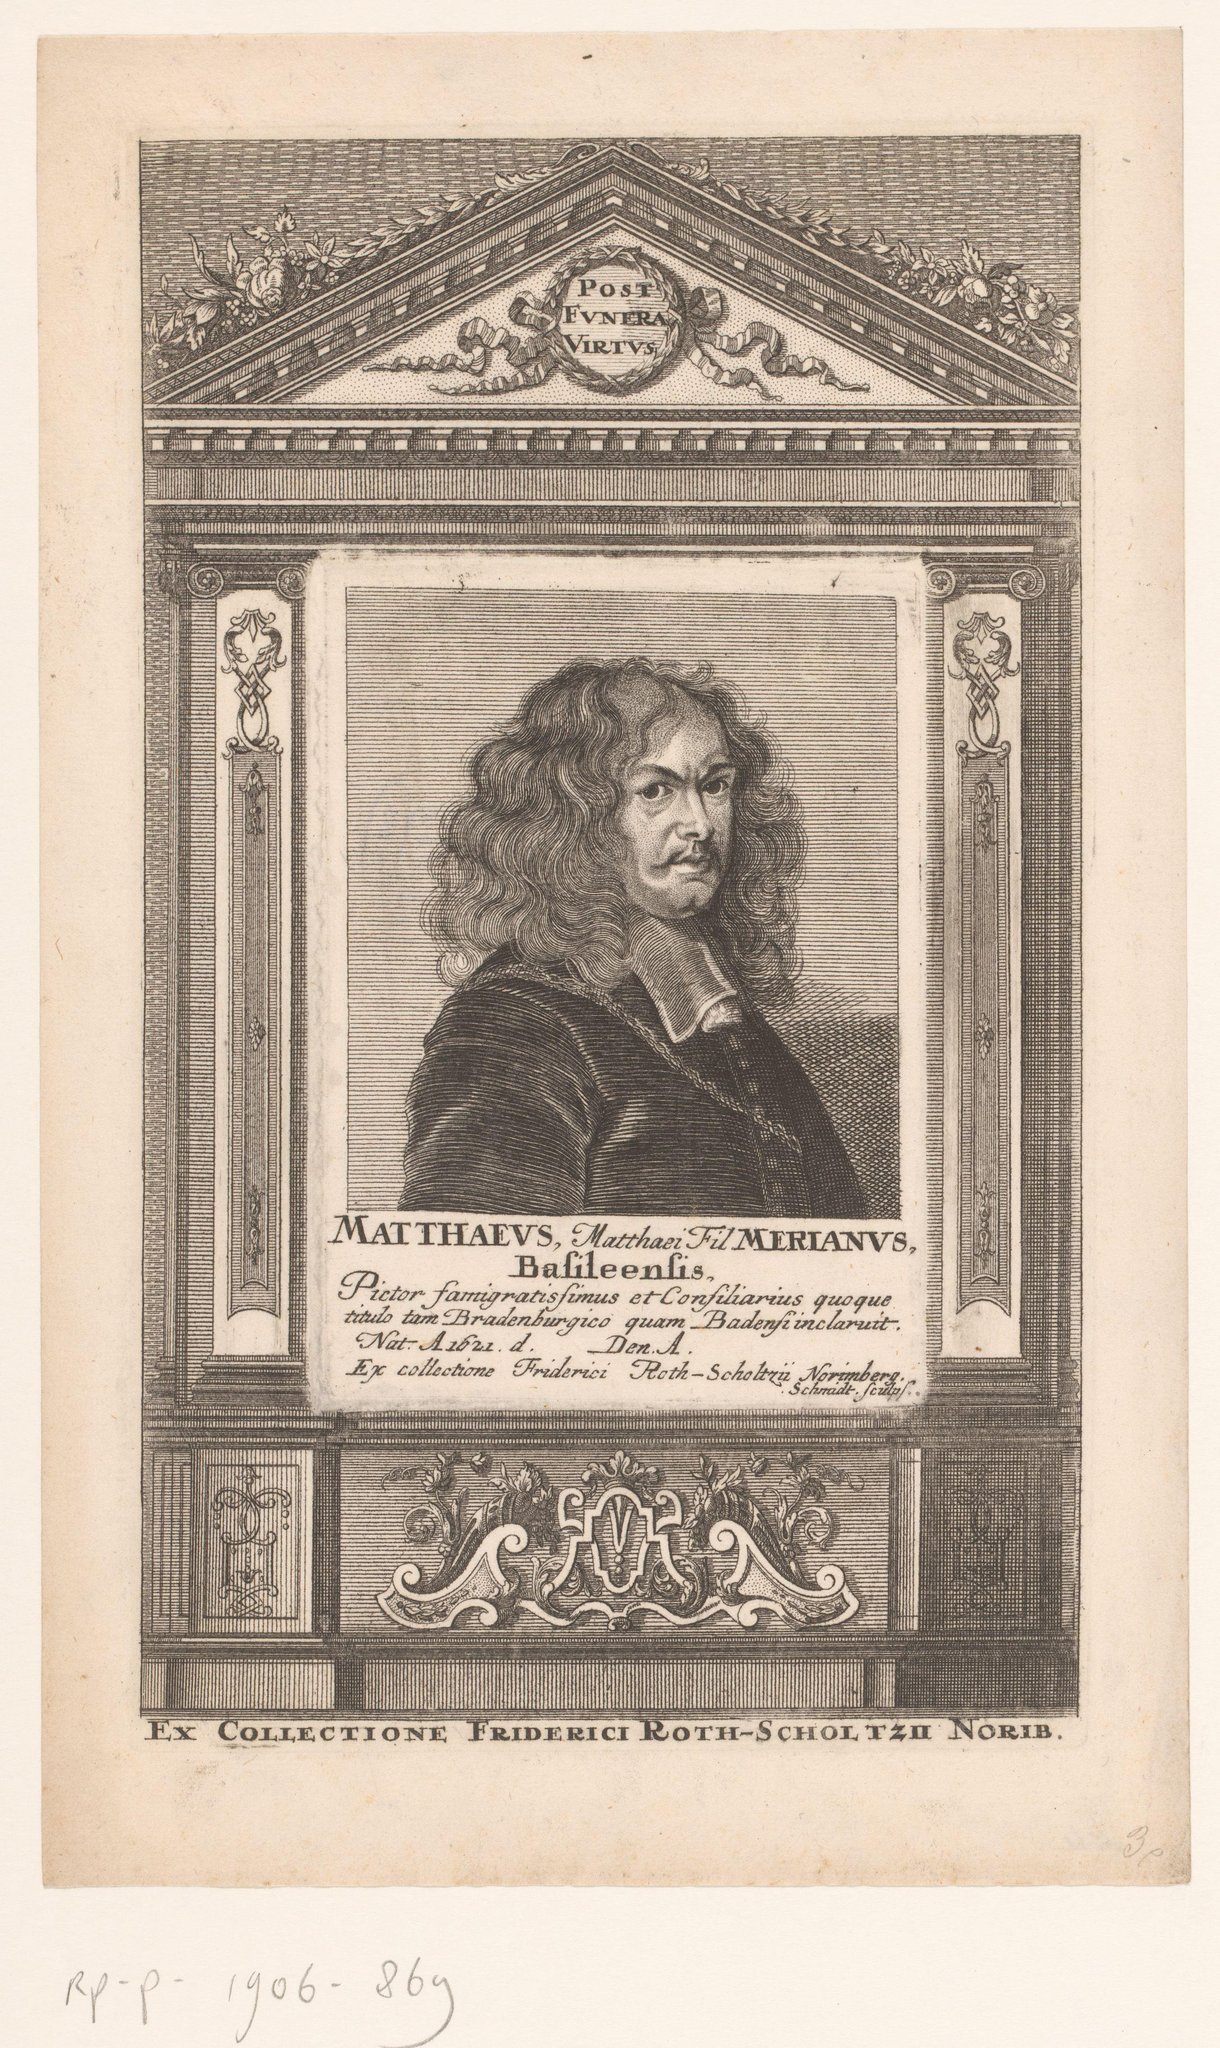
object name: print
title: Portret van Mathhaeus Merian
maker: johann friedrich schmidt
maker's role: print maker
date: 1704-1765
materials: paper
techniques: engraving, etching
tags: painter, historical persons, portrait, self-portrait of artist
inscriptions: collector's mark: Lugt 2228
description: Met architectonische omlijsting gedrukt van een andere plaat.